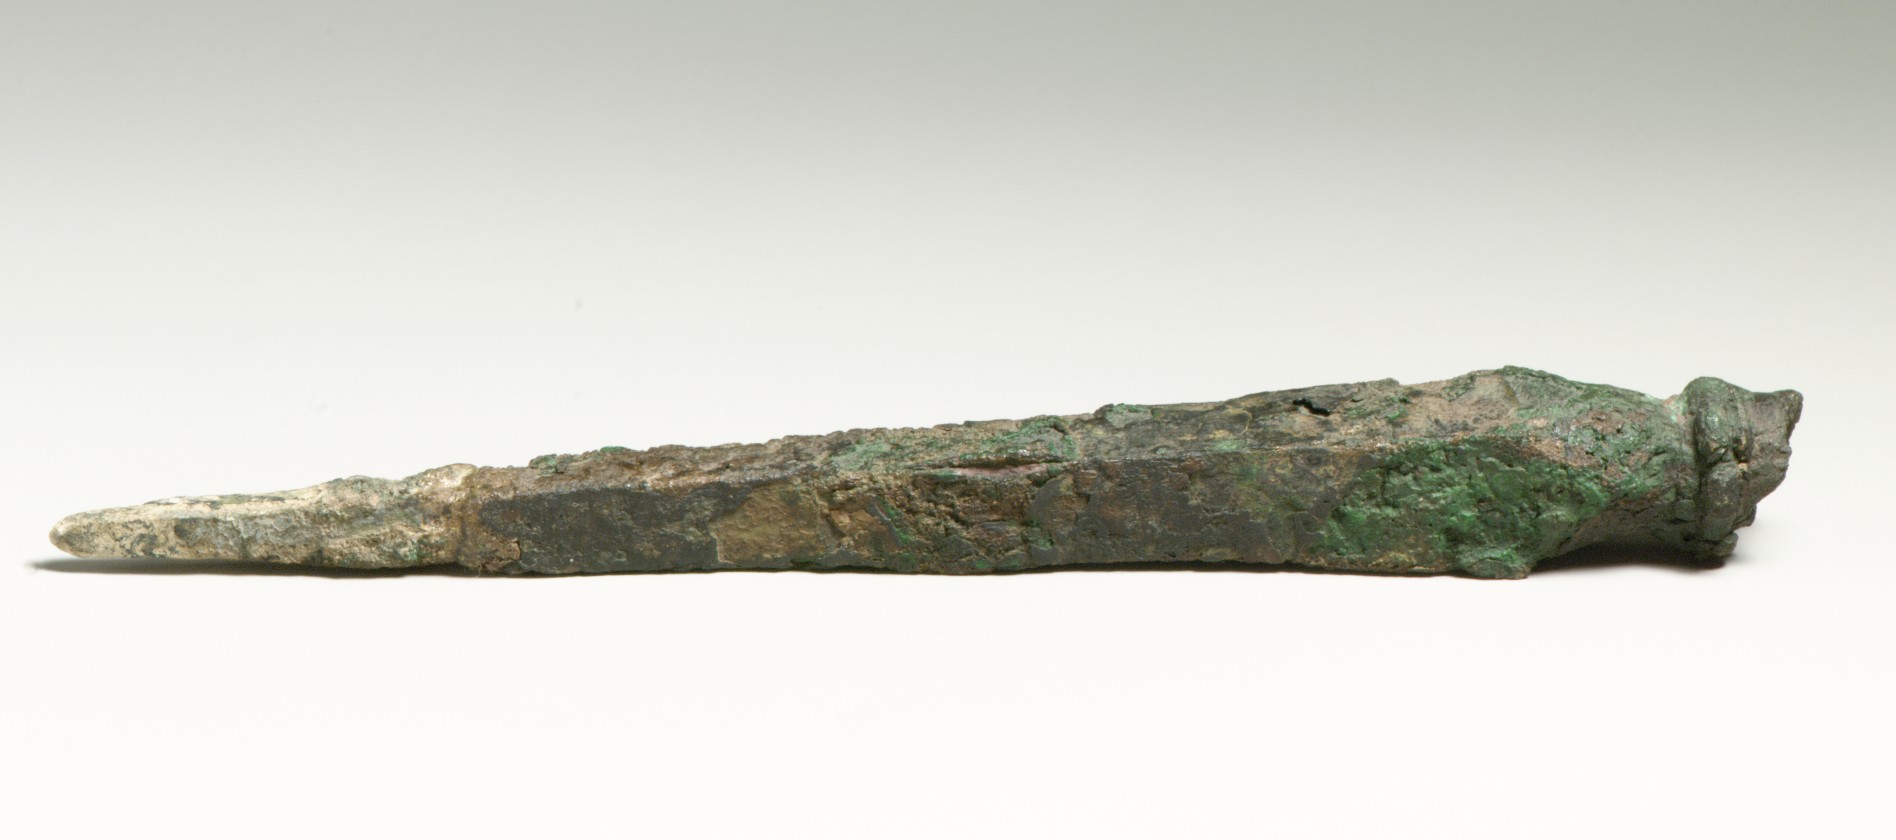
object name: spear butt, spike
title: Spear-butt, spike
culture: cypriot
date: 1050-1000 BCE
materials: bronze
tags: spears